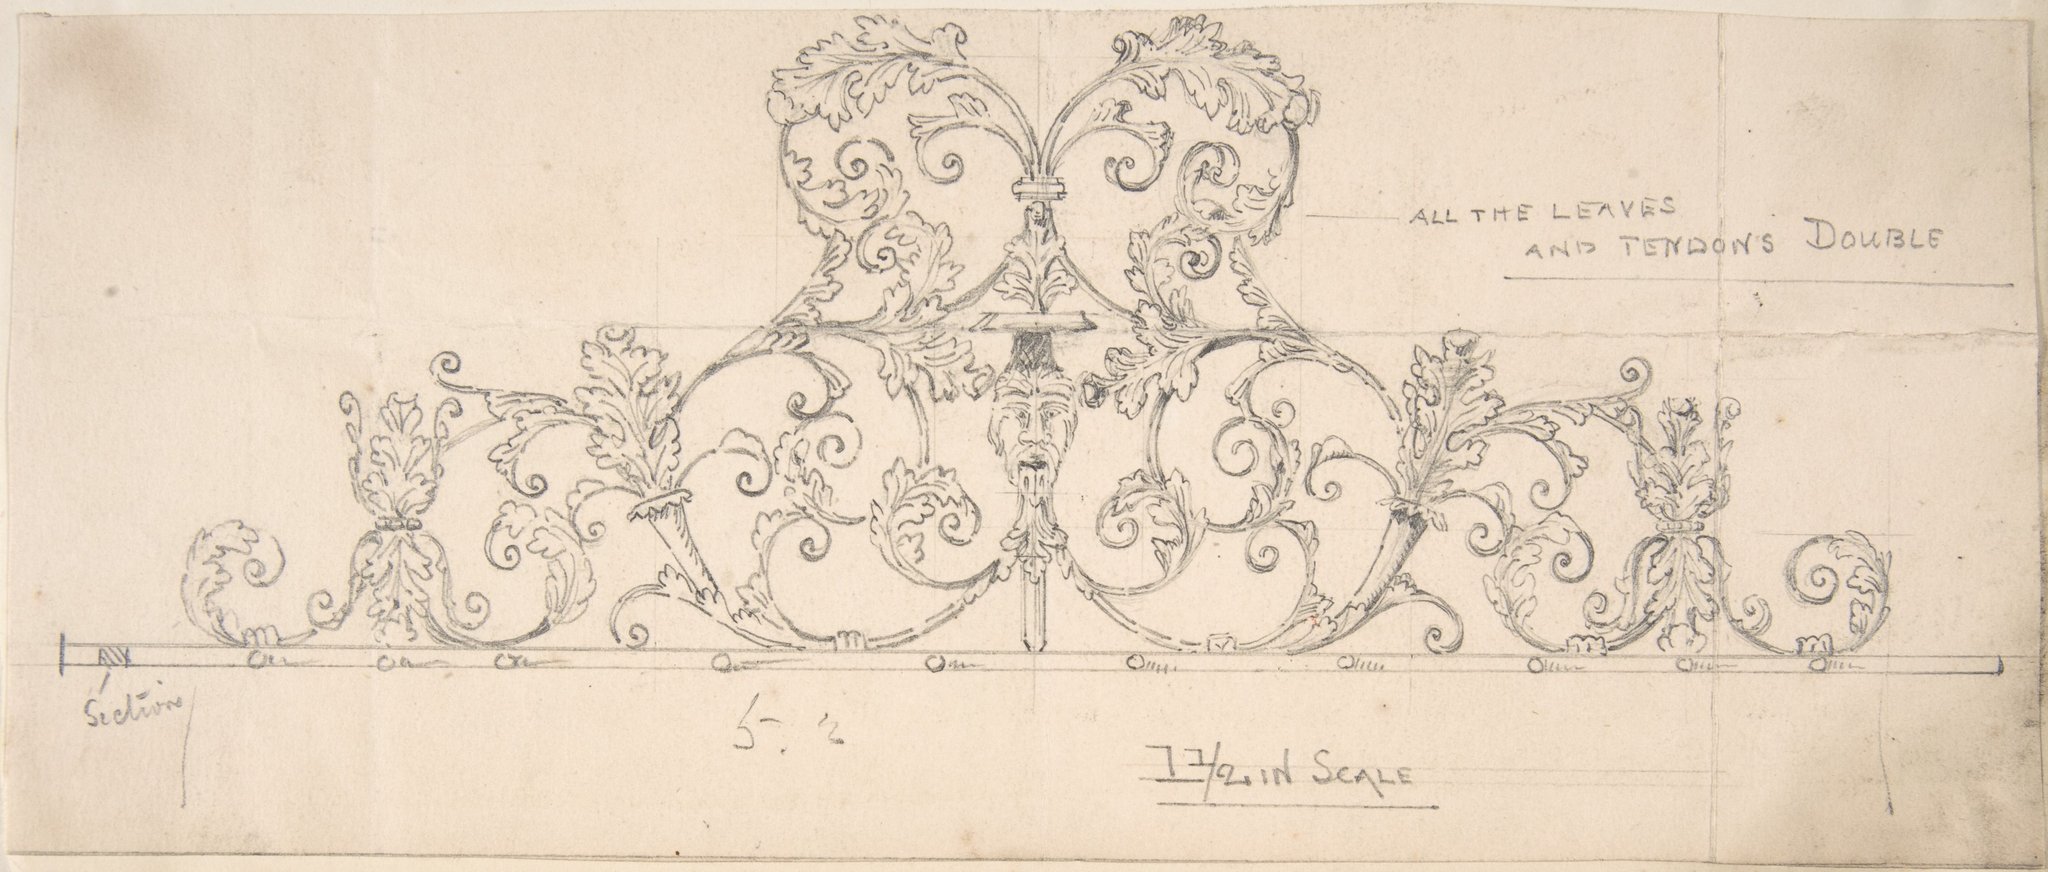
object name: drawing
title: Wrought Metal Foliate Ornament with Grotesque Masks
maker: anonymous, british, 19th century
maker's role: artist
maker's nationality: british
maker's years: 1800-1900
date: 1870-1890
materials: graphite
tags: grotesques,ornament